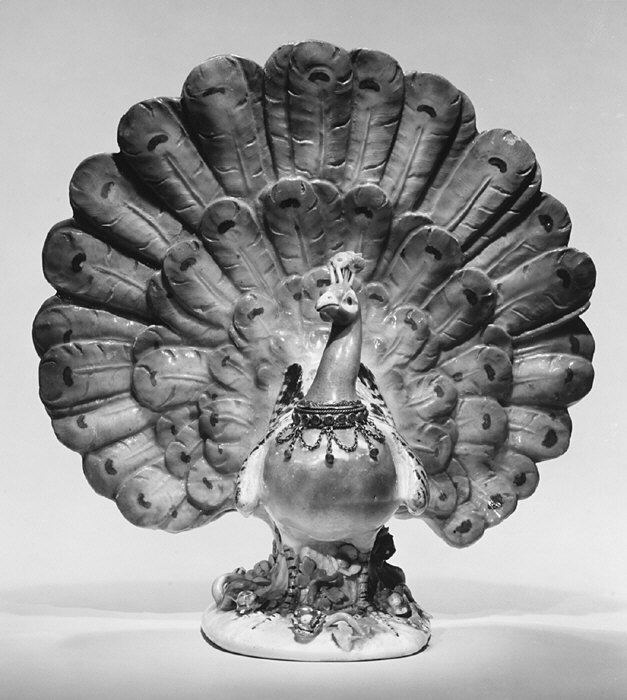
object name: figure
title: Peacock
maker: meissen manufactory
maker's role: manufactory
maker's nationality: german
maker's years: 1710-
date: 1741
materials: hard paste porcelain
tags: peacocks